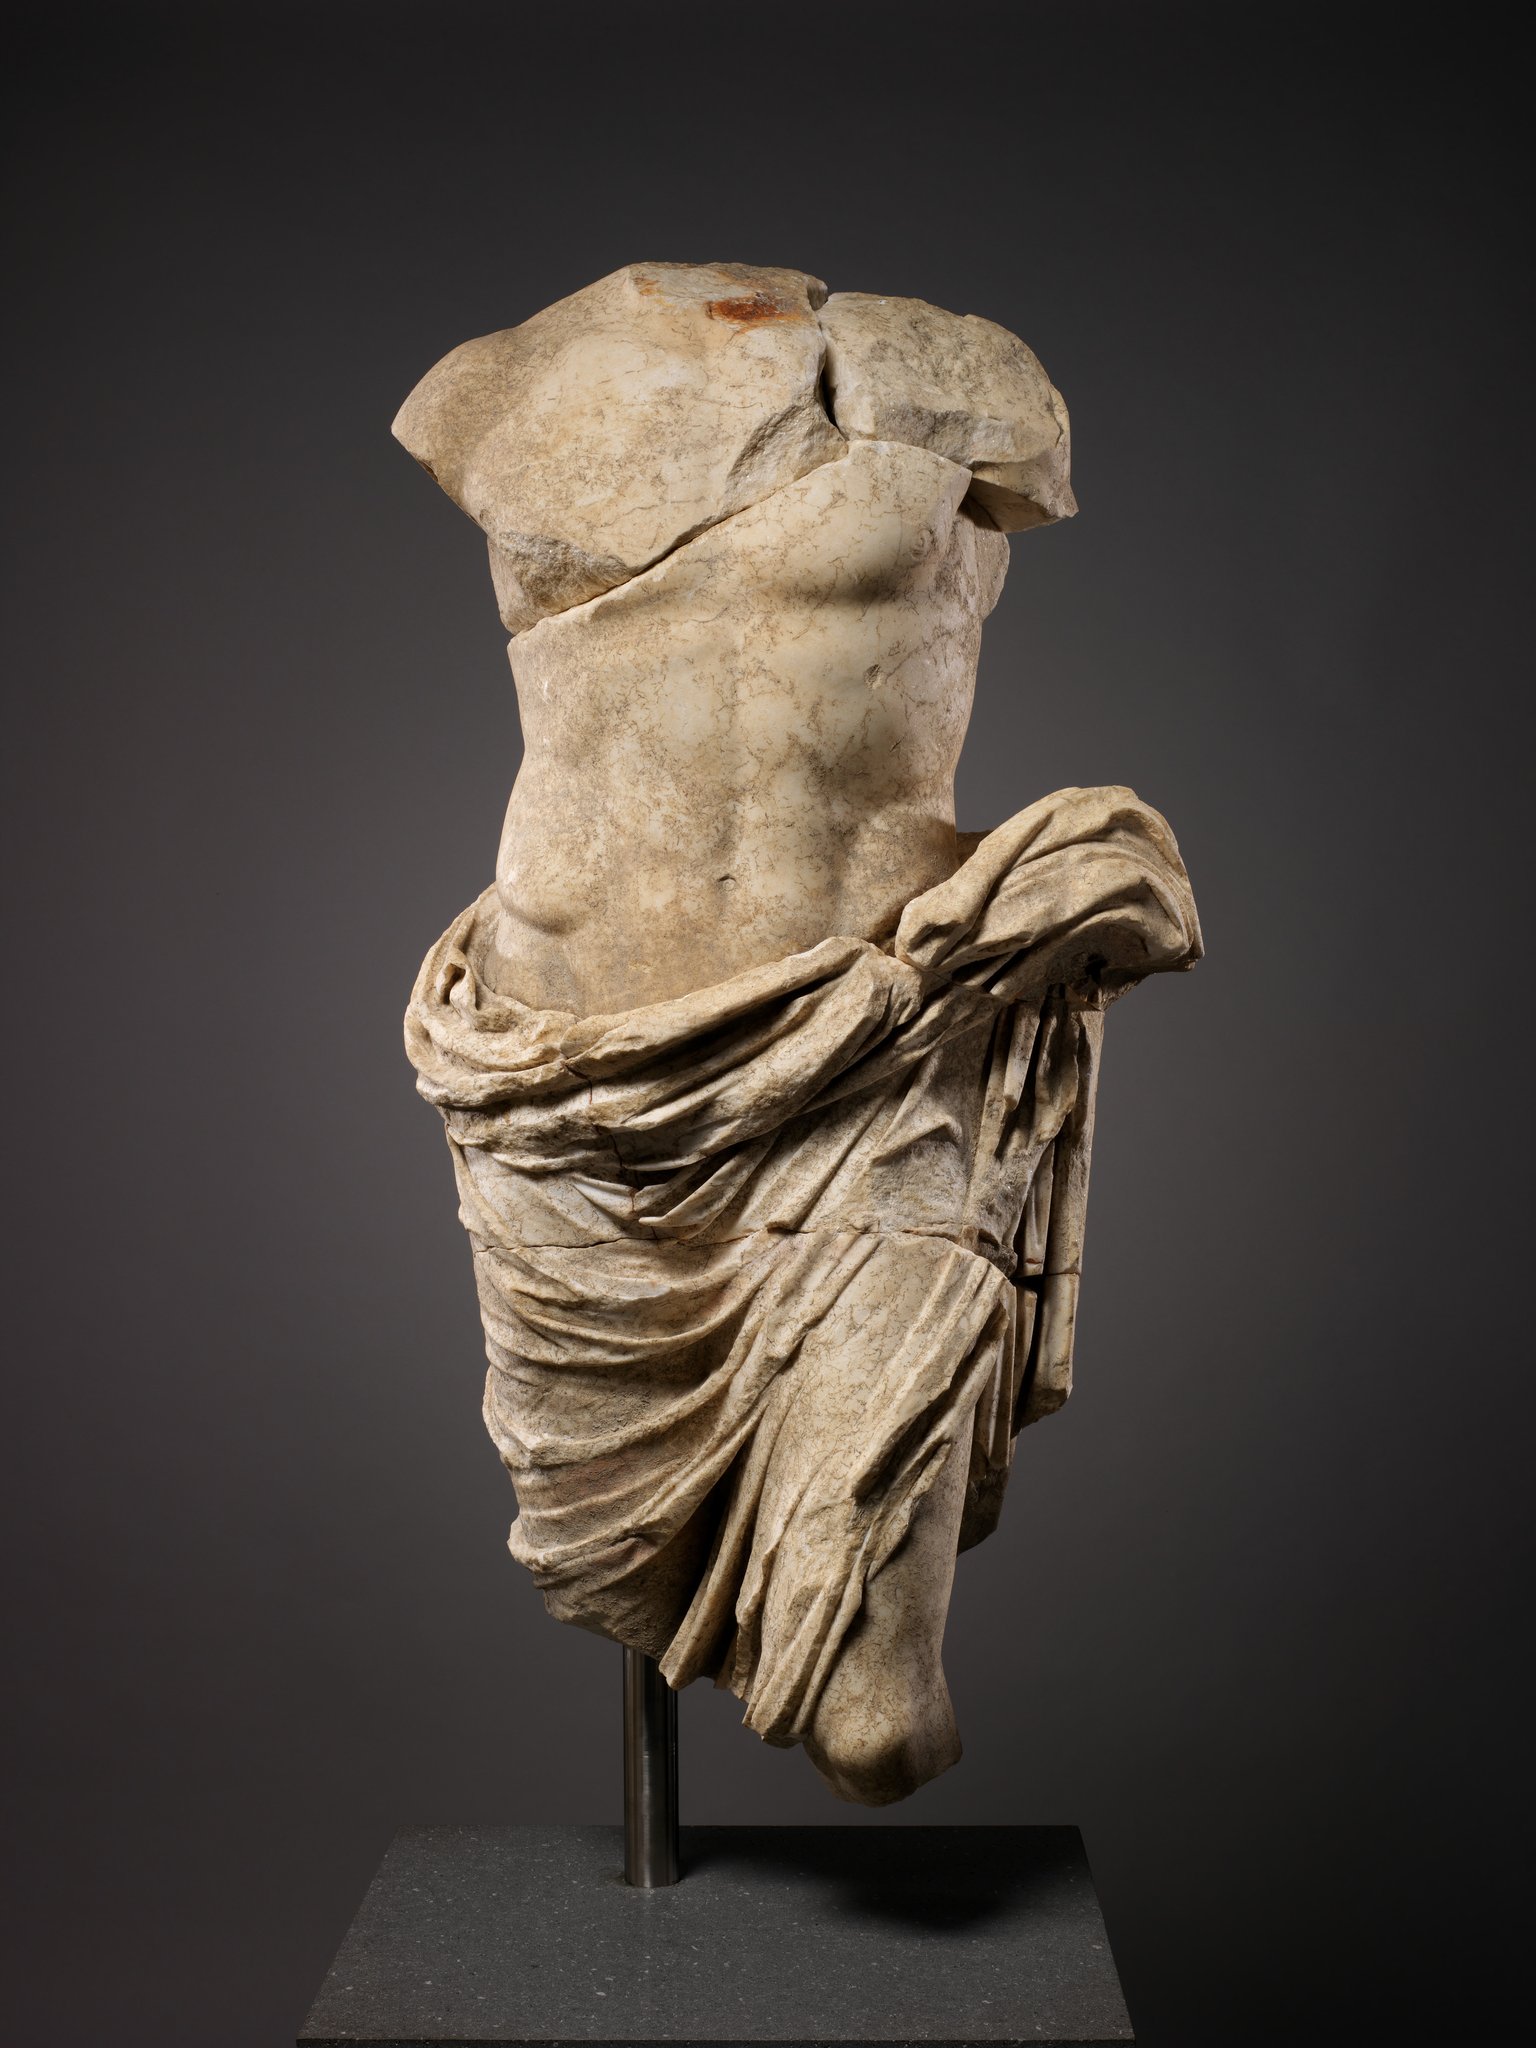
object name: statue of a young man, half draped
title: Marble statue of a member of the imperial family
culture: roman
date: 27 BCE-68 CE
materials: marble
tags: men